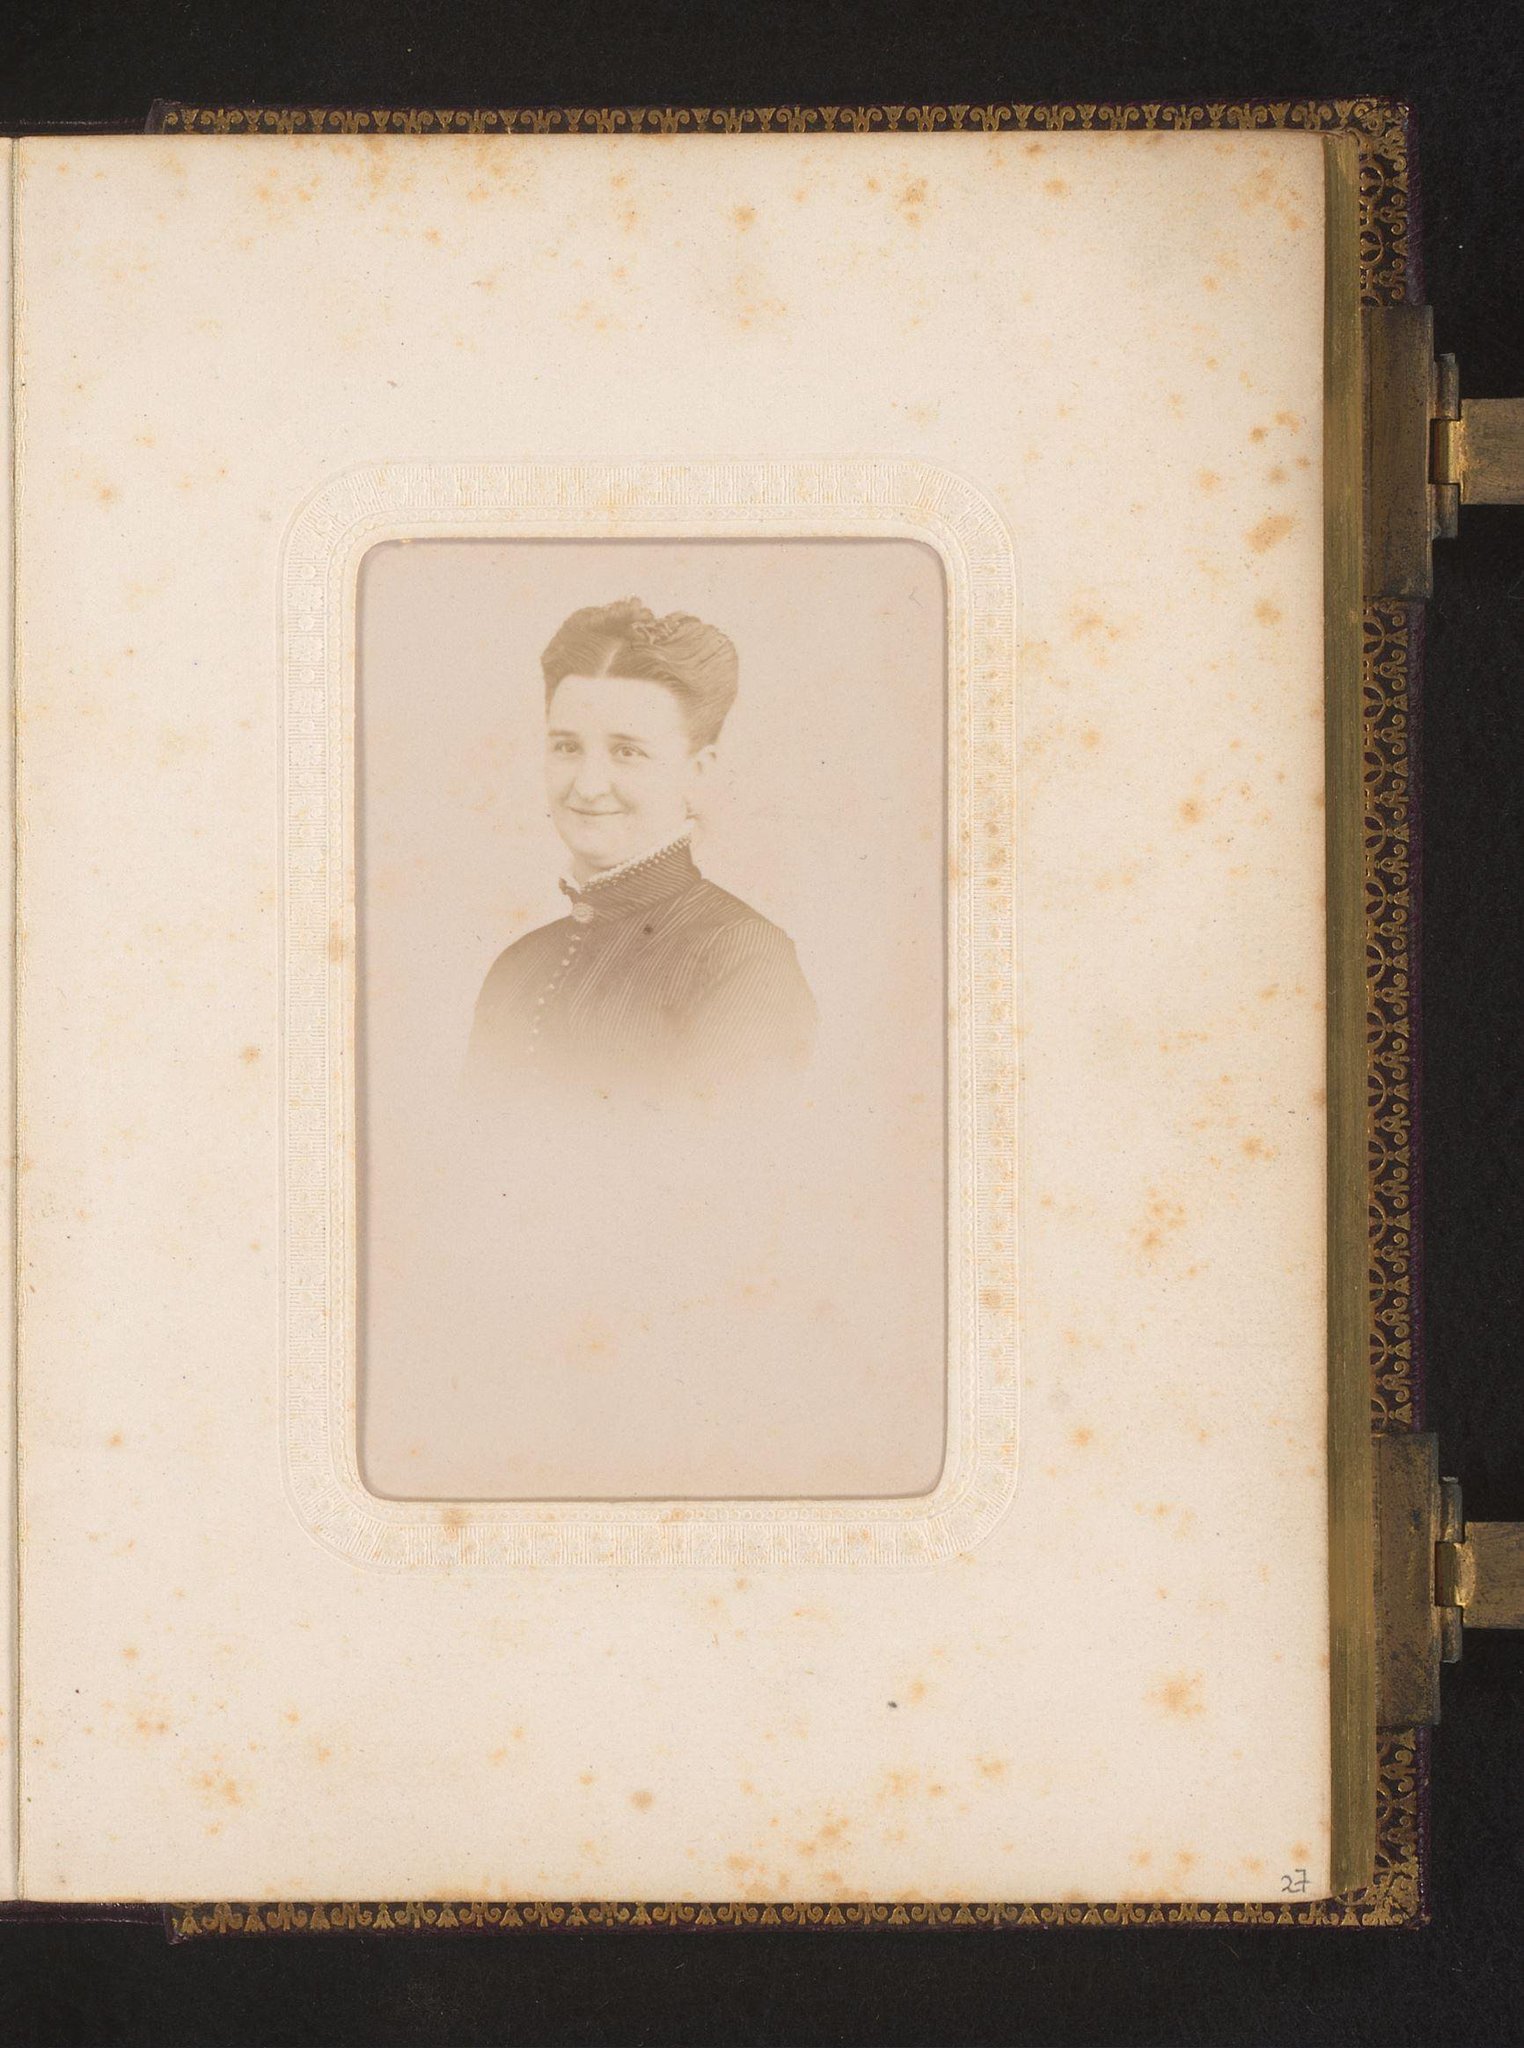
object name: album leaf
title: Portret van een vrouw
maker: Anonymous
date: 1860-1900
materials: cardboard, photographic support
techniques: albumen print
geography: france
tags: historical persons - bb - woman